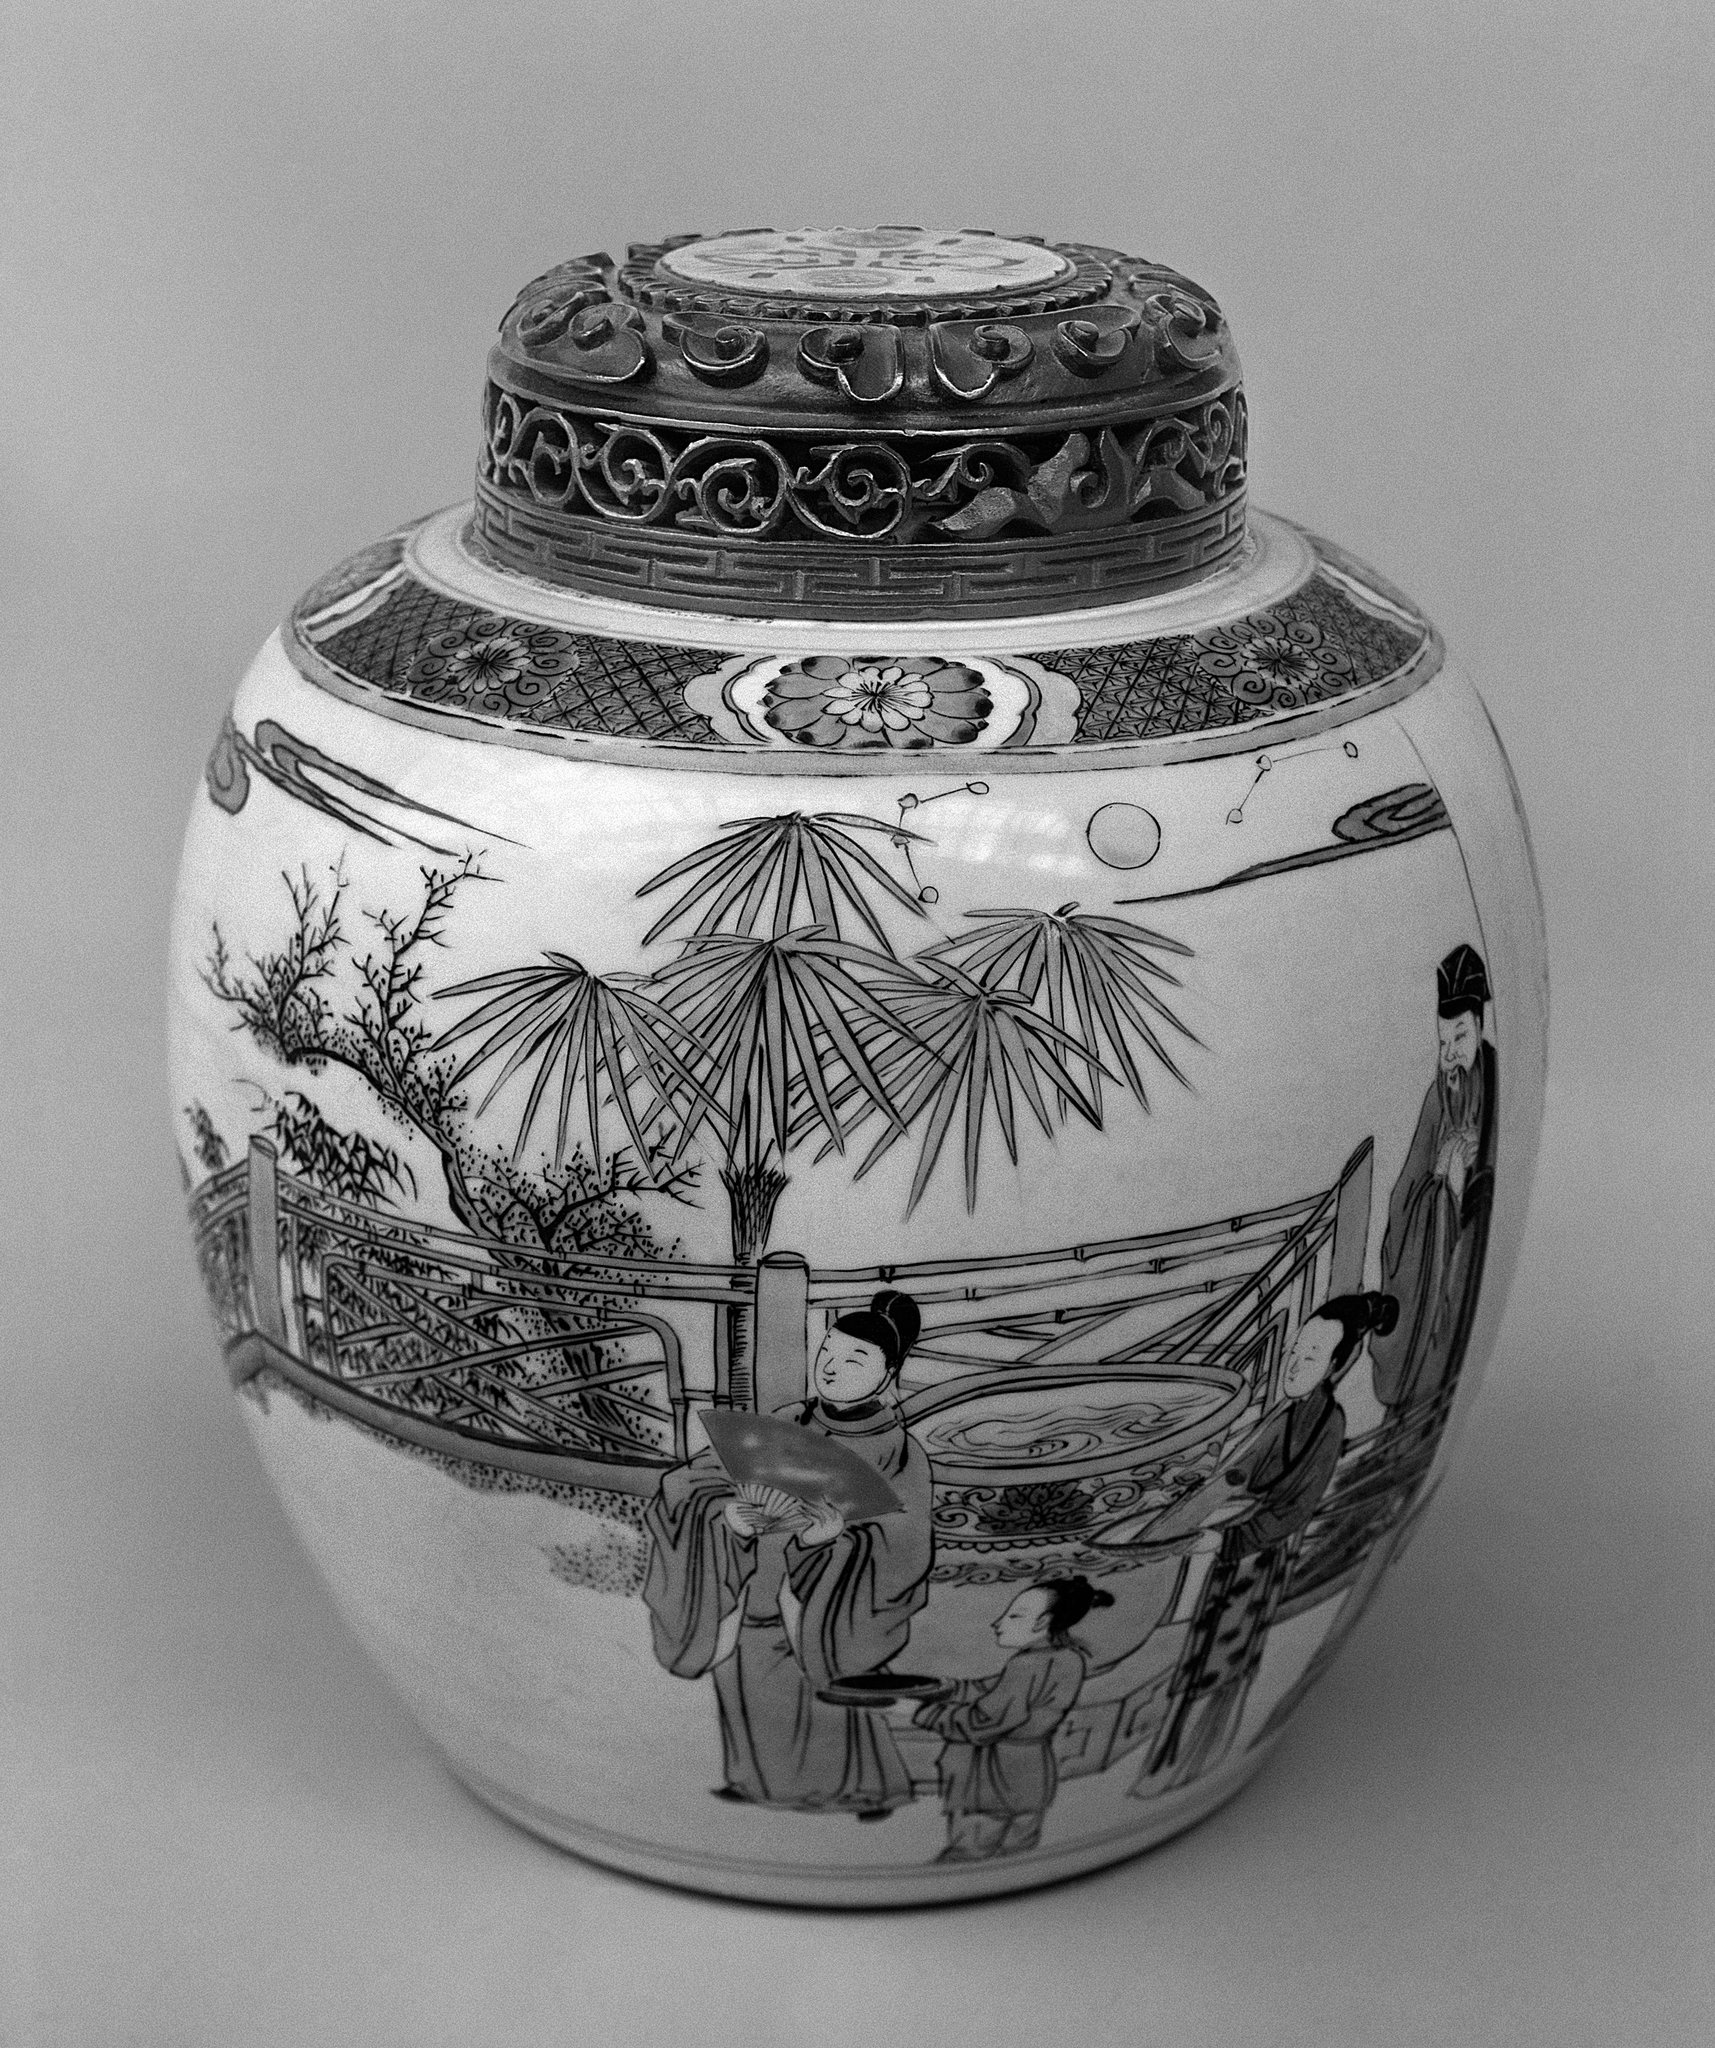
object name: jar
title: Jar with figures in a garden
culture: chinese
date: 1667-1733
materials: enamel, porcelain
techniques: overglaze, painting, polychrome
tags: boys,men